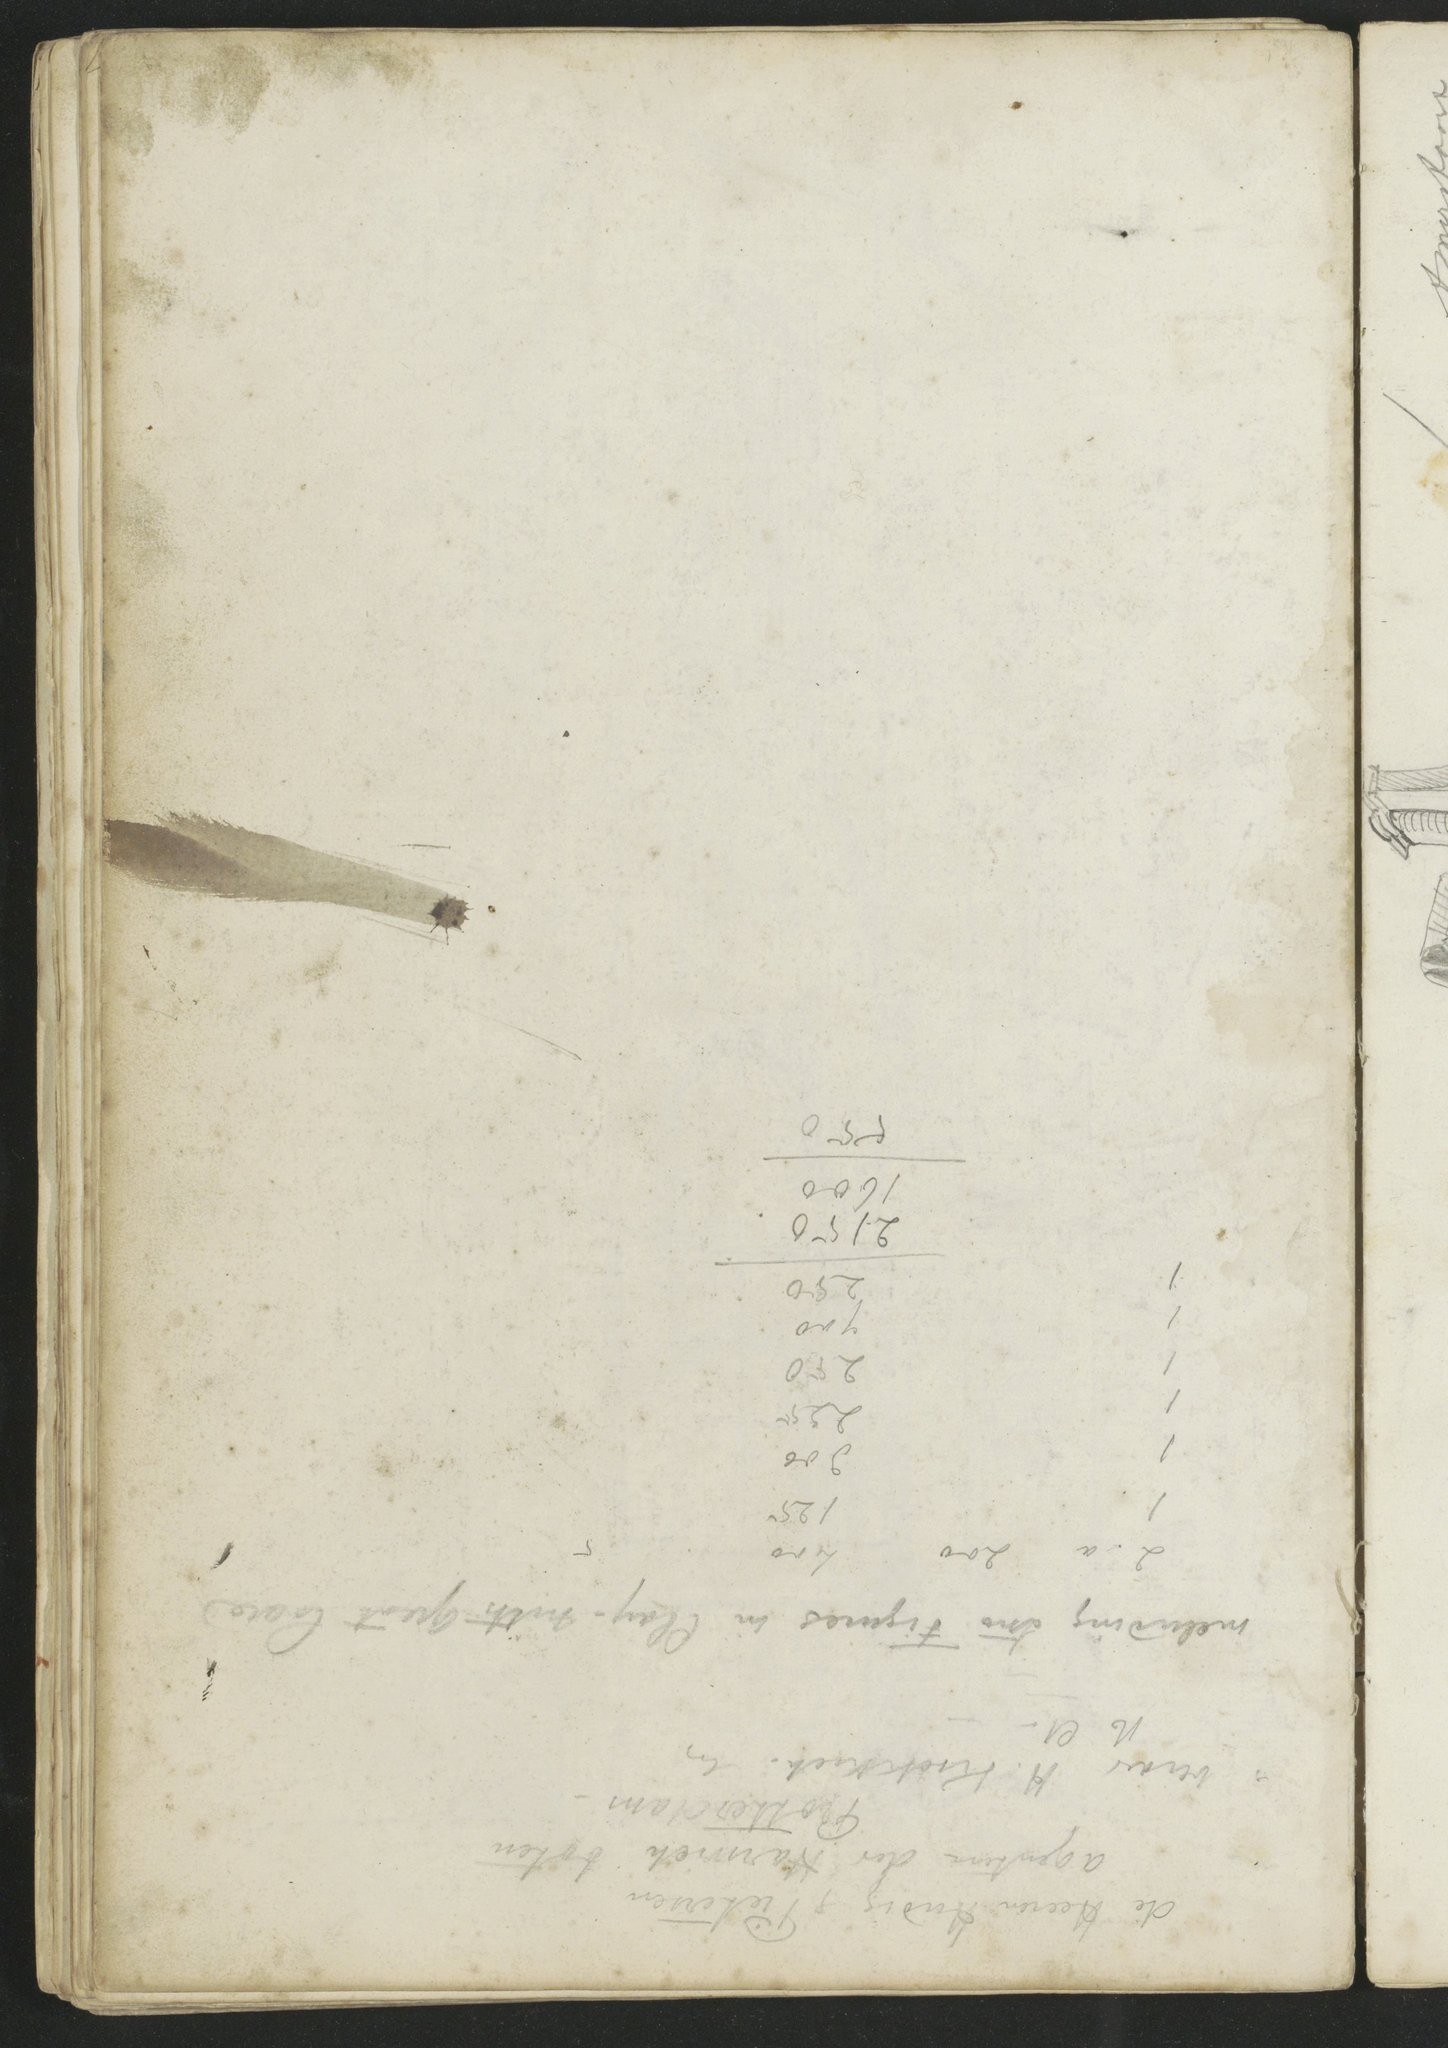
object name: sketchbook leaf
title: Notities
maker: willem koekkoek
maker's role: draughtsman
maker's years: 1839-1895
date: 1849-1895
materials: paper, pencil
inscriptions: annotation: ‘de Heeren Andig & Pietersen/ agenten der Harwiek boten/ Rotterdam/ verder A. Koekkoek en/ n [...]/ [...] Figures in Clay - [...]’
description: Blad 38 verso uit een schetsboek met 42 bladen.